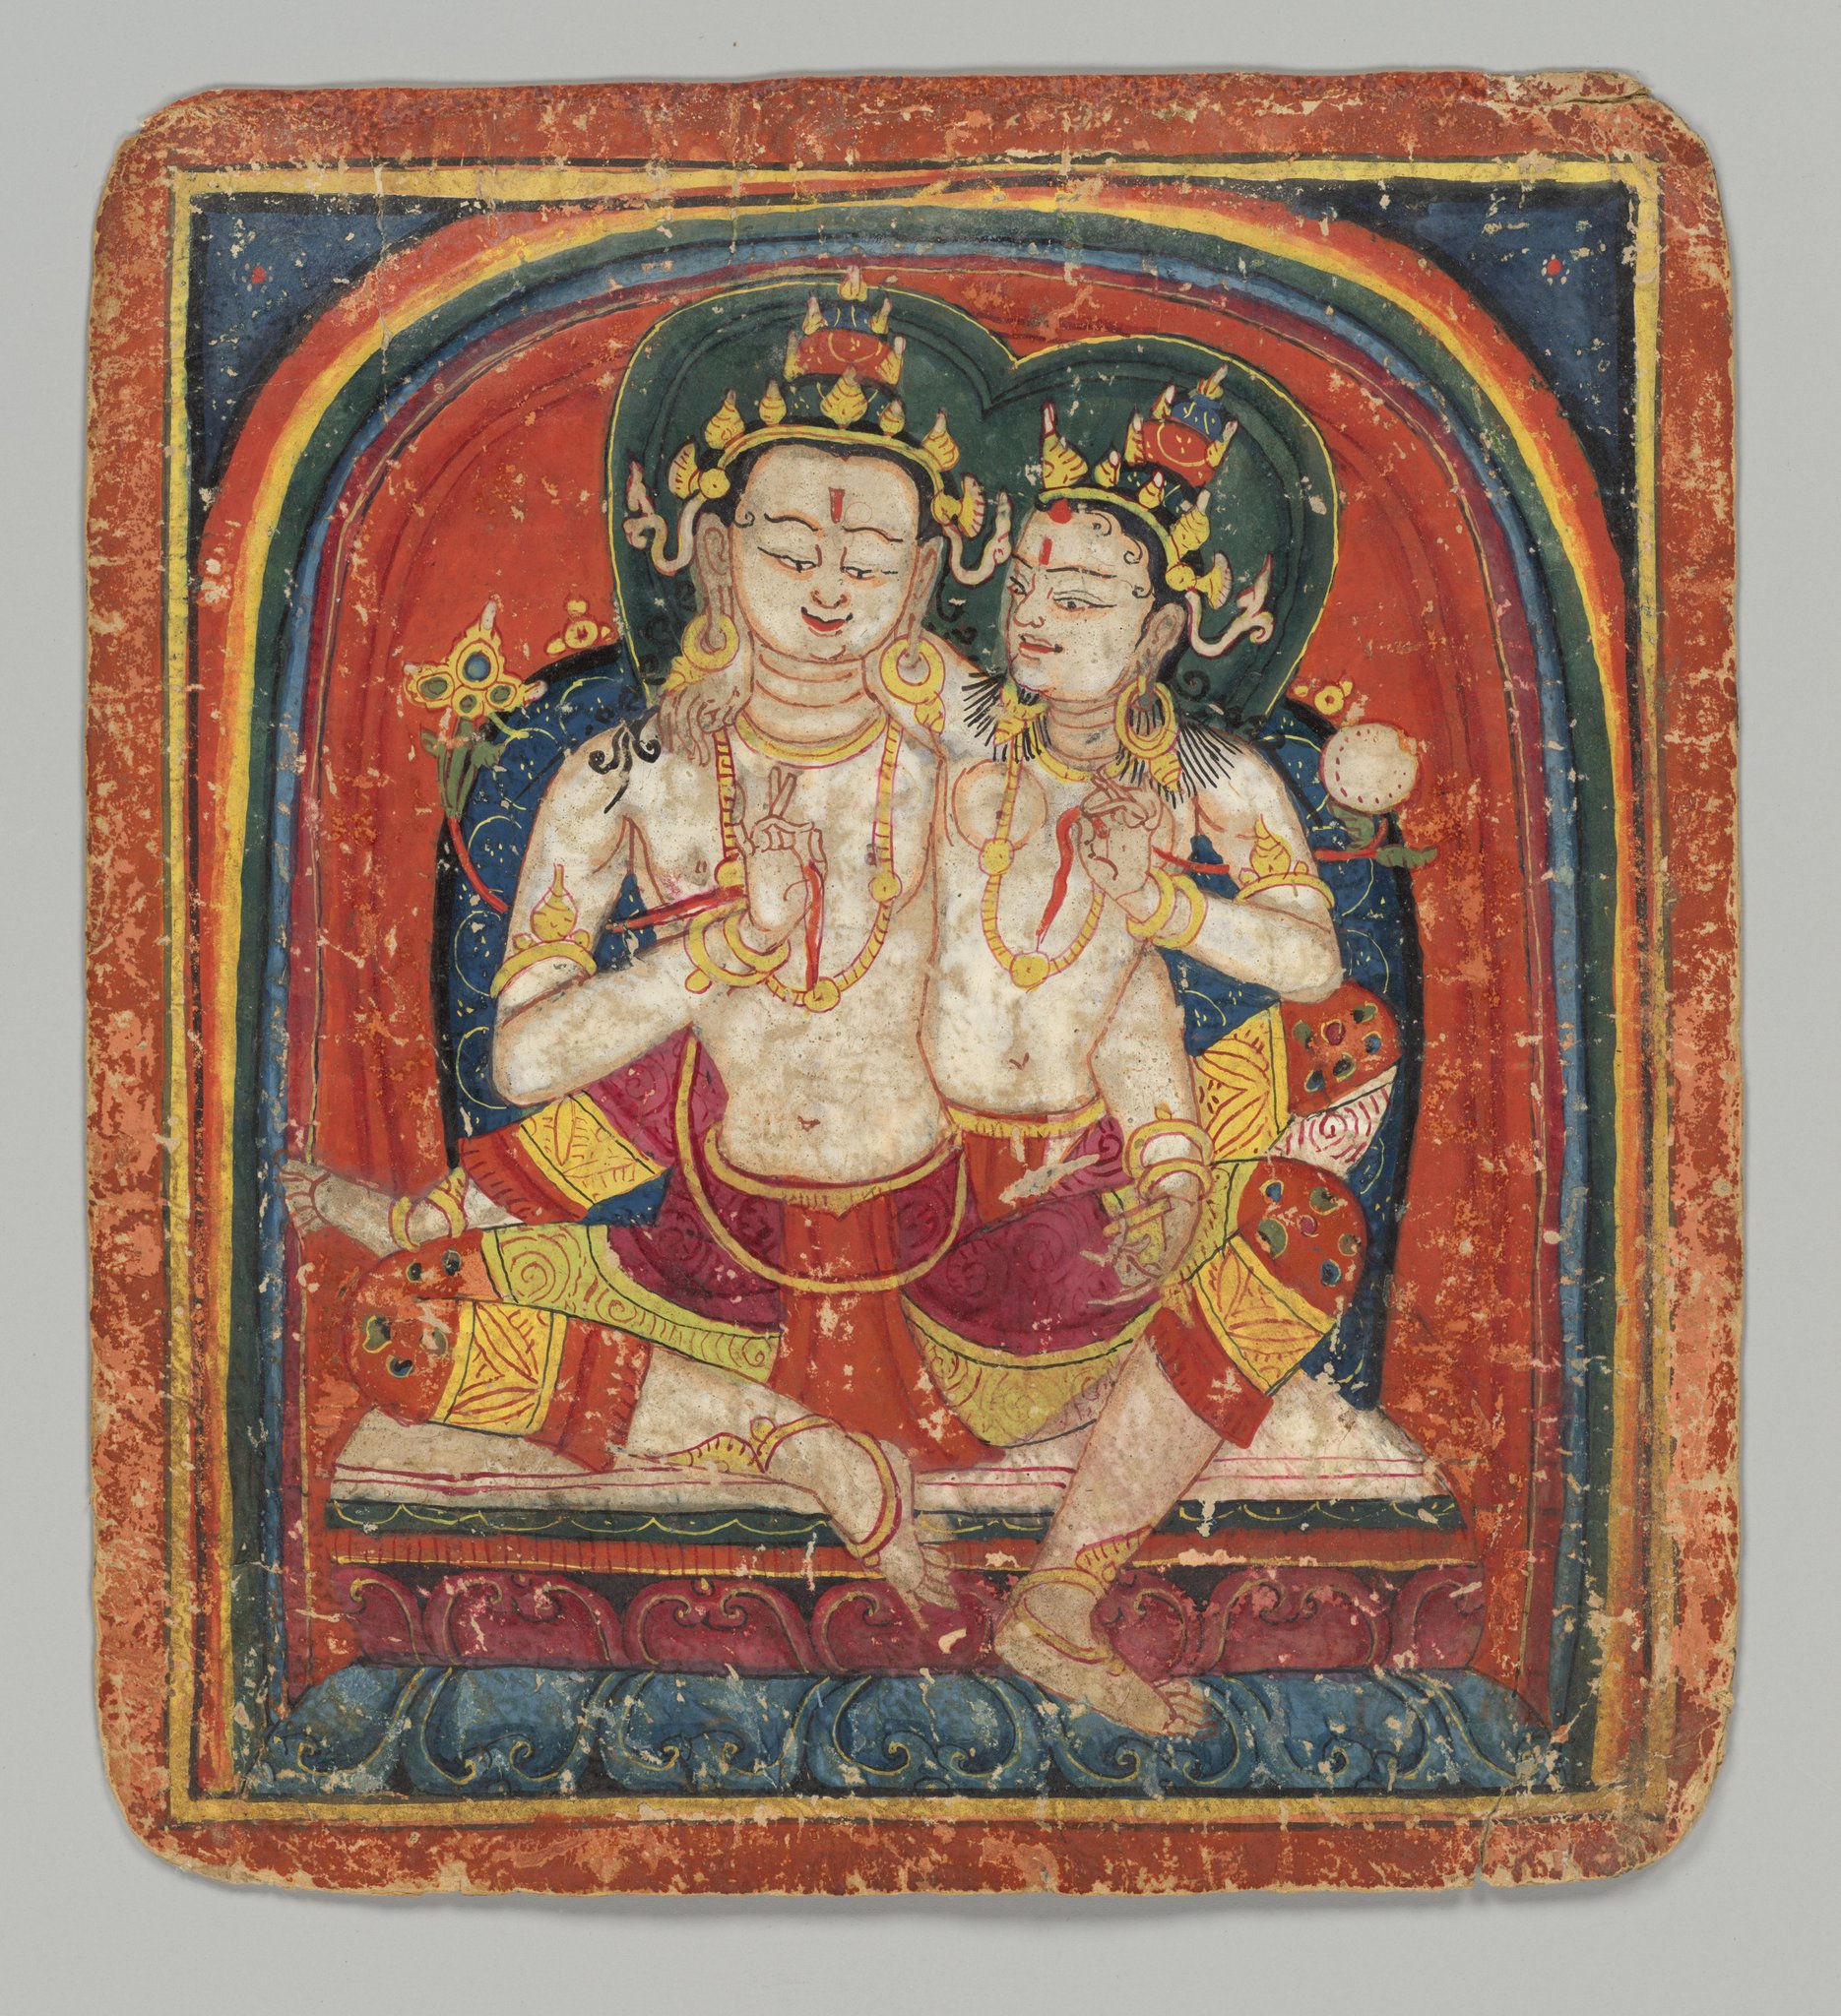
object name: initiation card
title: Initiation Card (Tsakalis): Bhumirgharba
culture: tibetan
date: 1401-1433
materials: paper, watercolor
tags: buddhism,deities